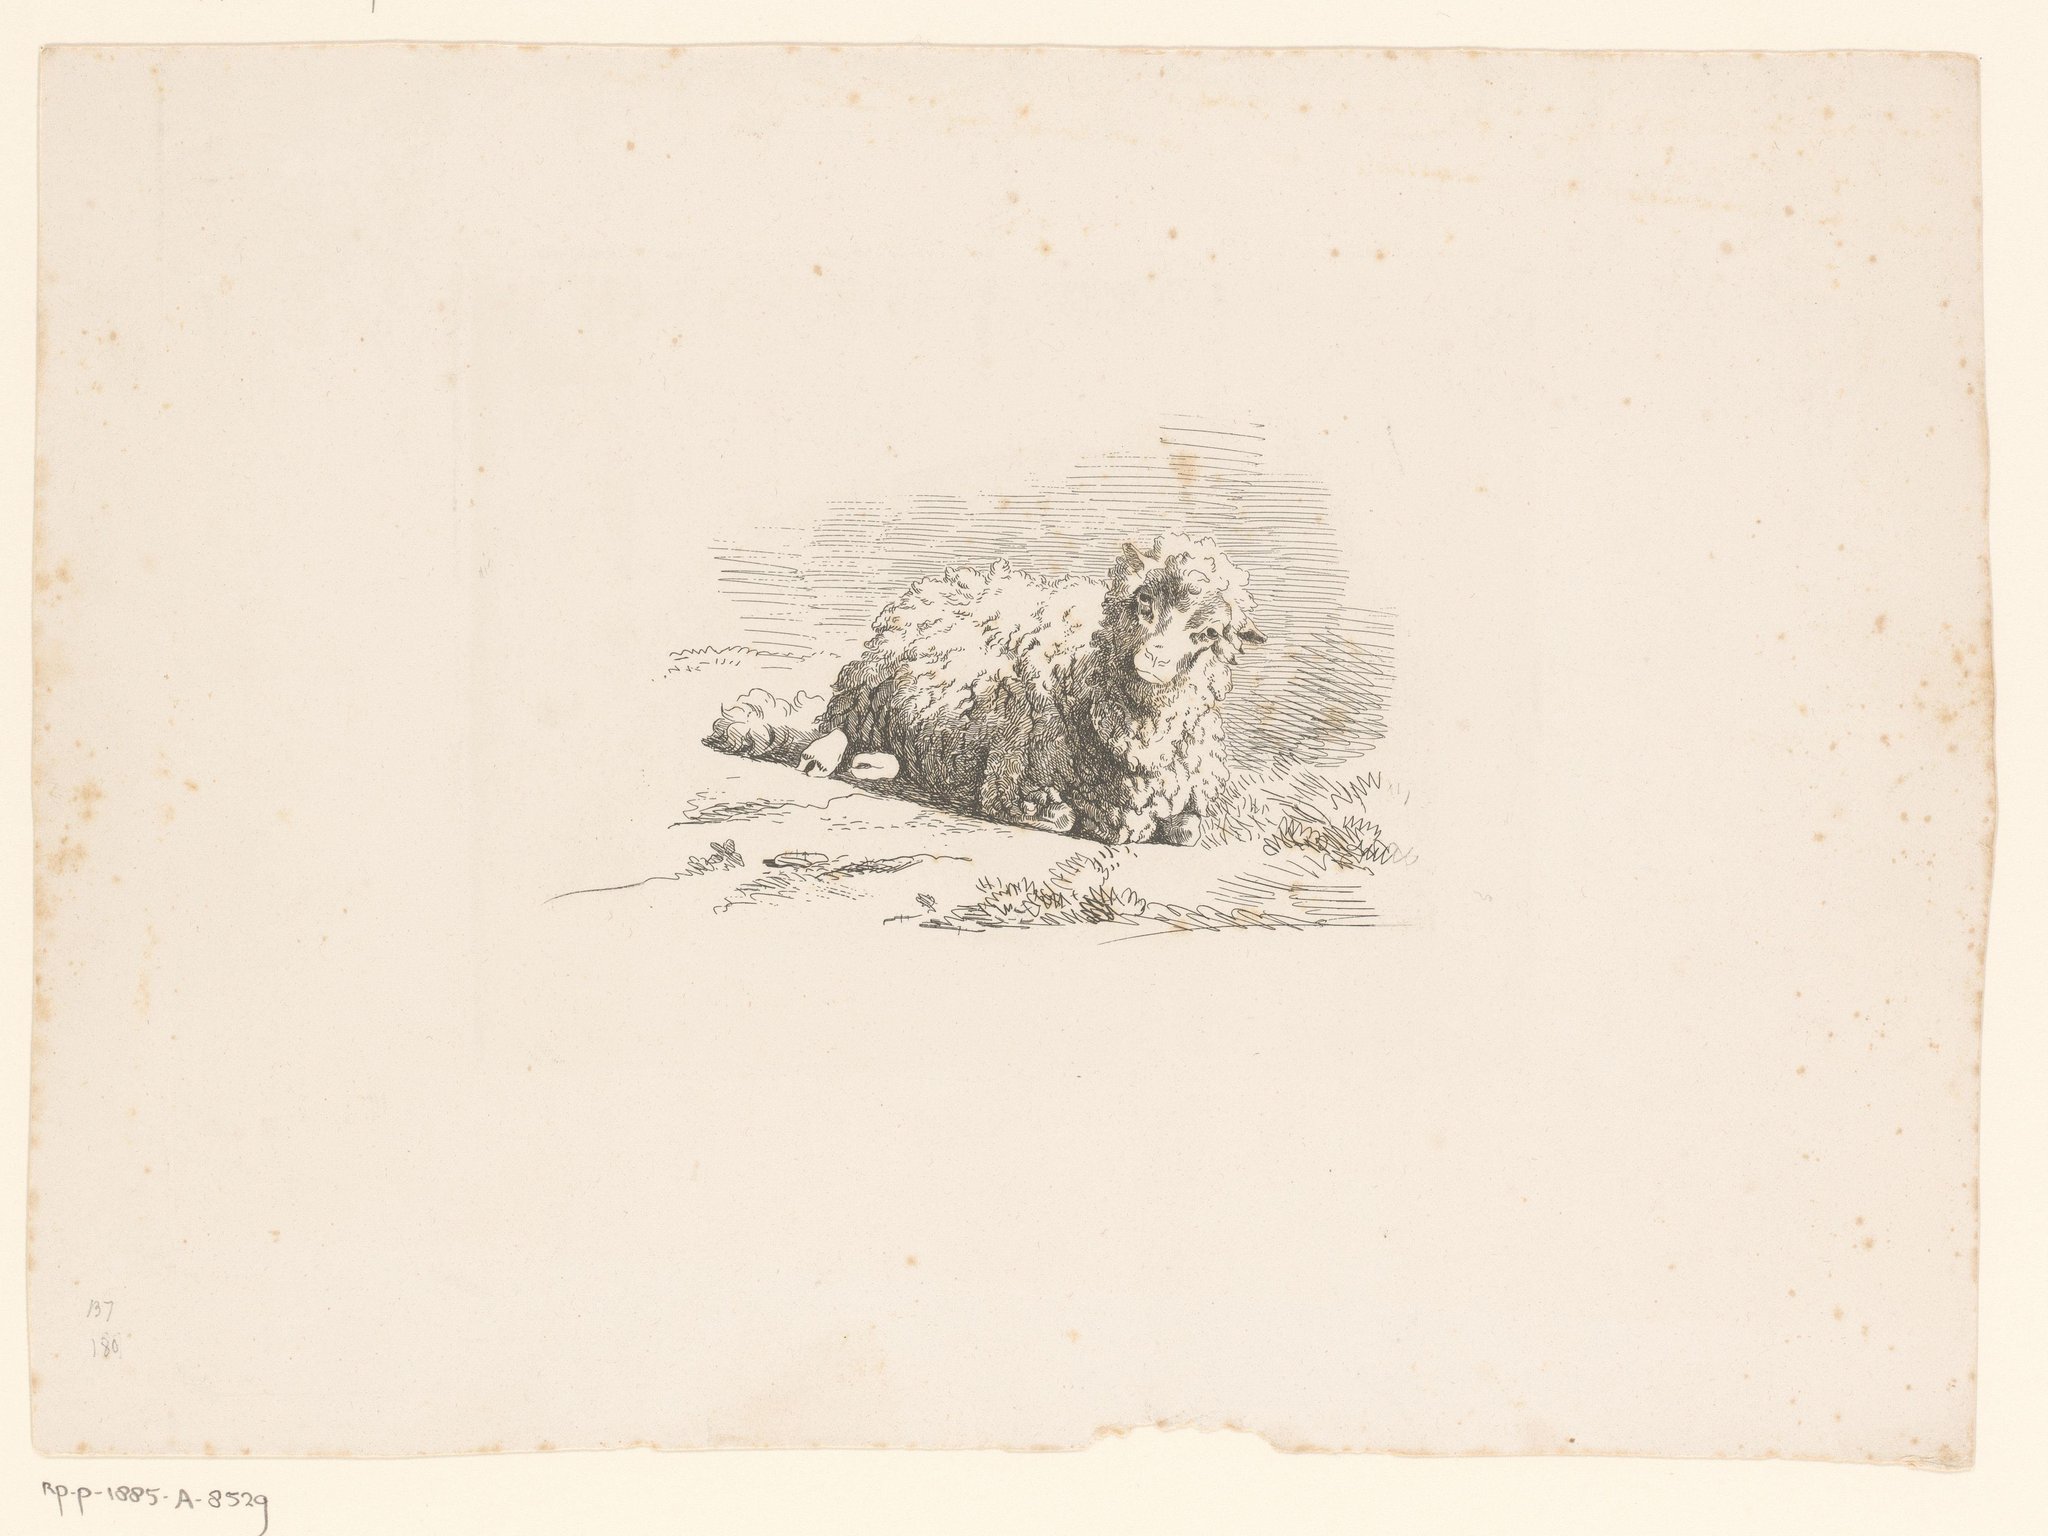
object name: print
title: Liggend schaap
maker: edmond tschaggeny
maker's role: print maker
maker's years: 1818-1873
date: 1828-1873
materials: paper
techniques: etching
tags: sheep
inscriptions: collector's mark: Lugt 2228